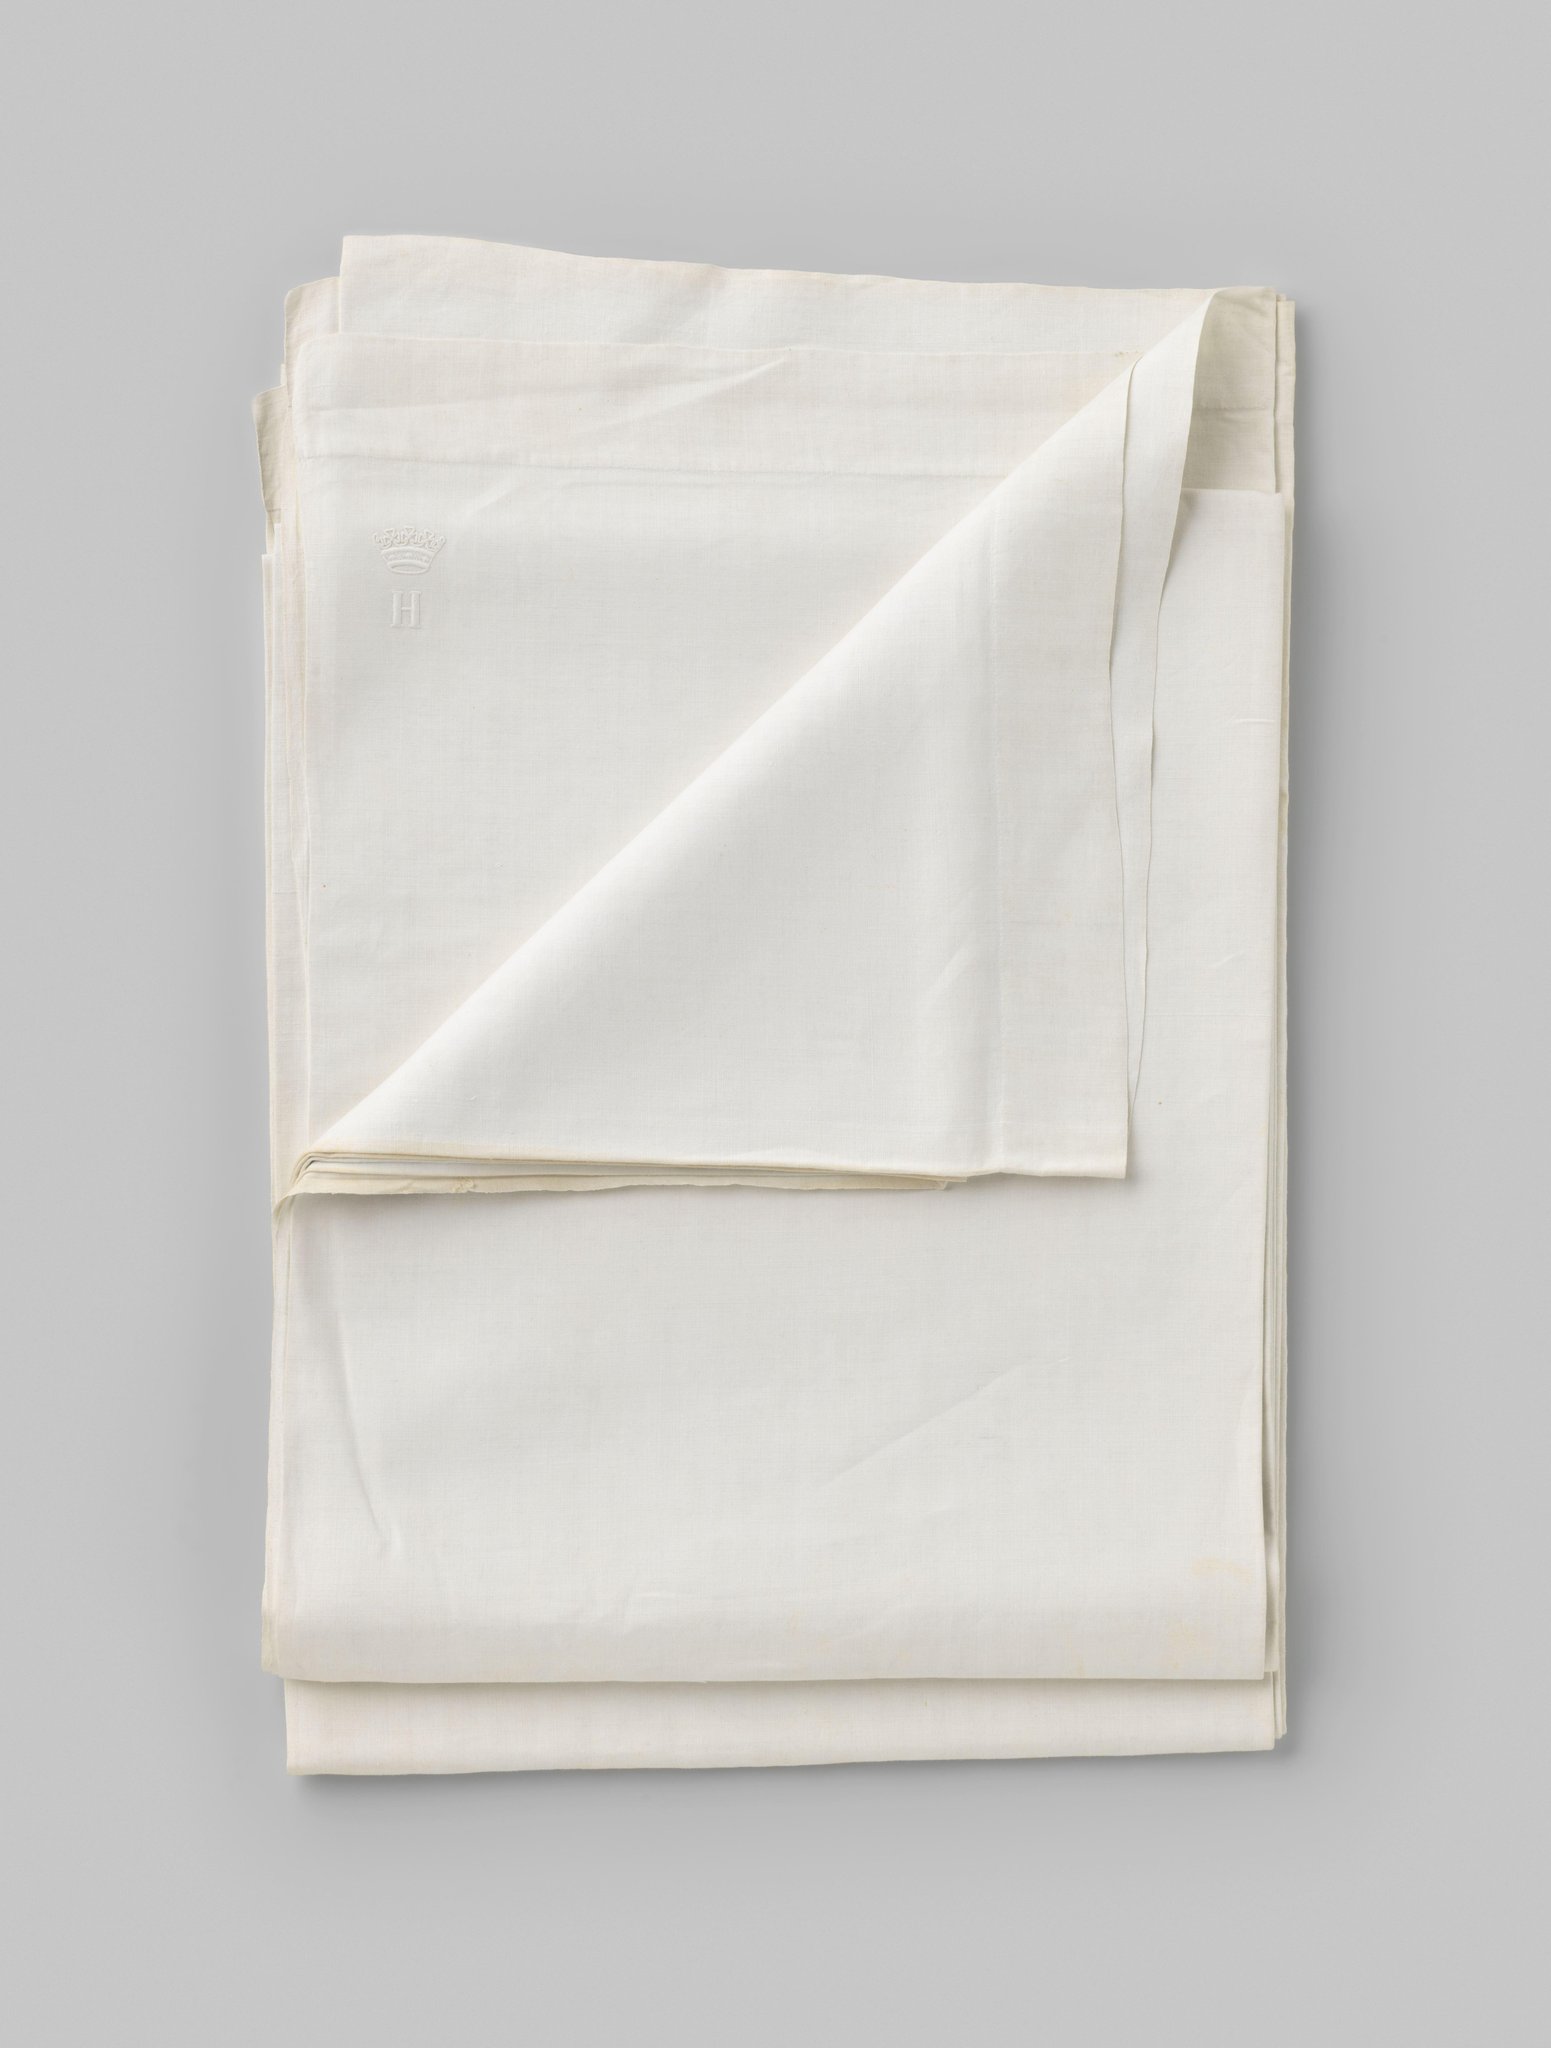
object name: beddenlaken, laken object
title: Laken. Merk: kroon H.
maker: Anonymous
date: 1890-1922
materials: linen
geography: northern netherlands